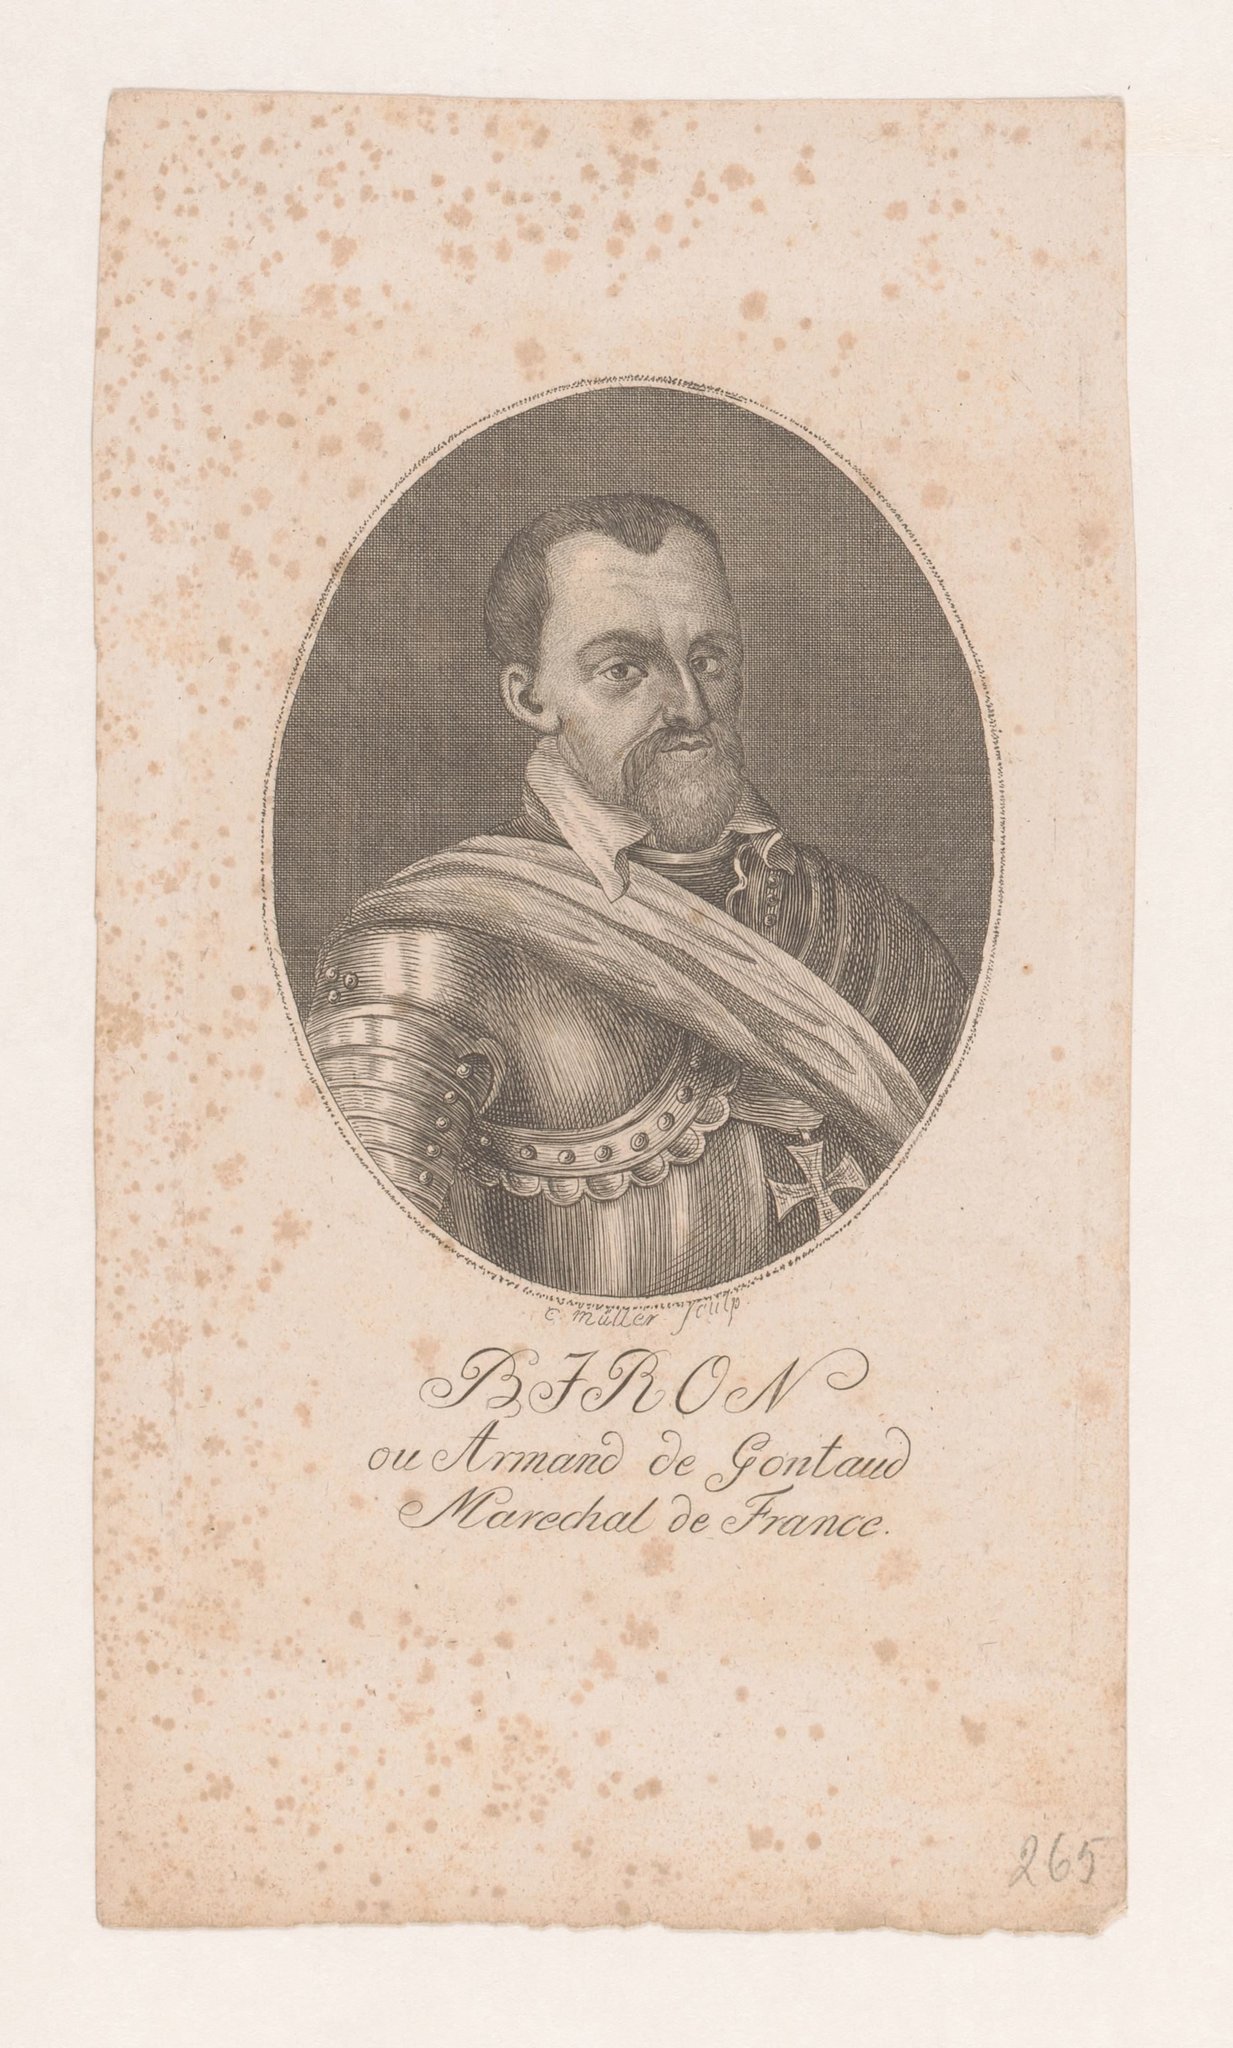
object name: print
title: Portret van Biron, heer van Armand de Gontaut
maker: c. müller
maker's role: print maker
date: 1700-1799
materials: paper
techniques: engraving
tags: politician, armour, historical persons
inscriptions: collector's mark: Lugt 2228, collector's mark: Lugt 2760